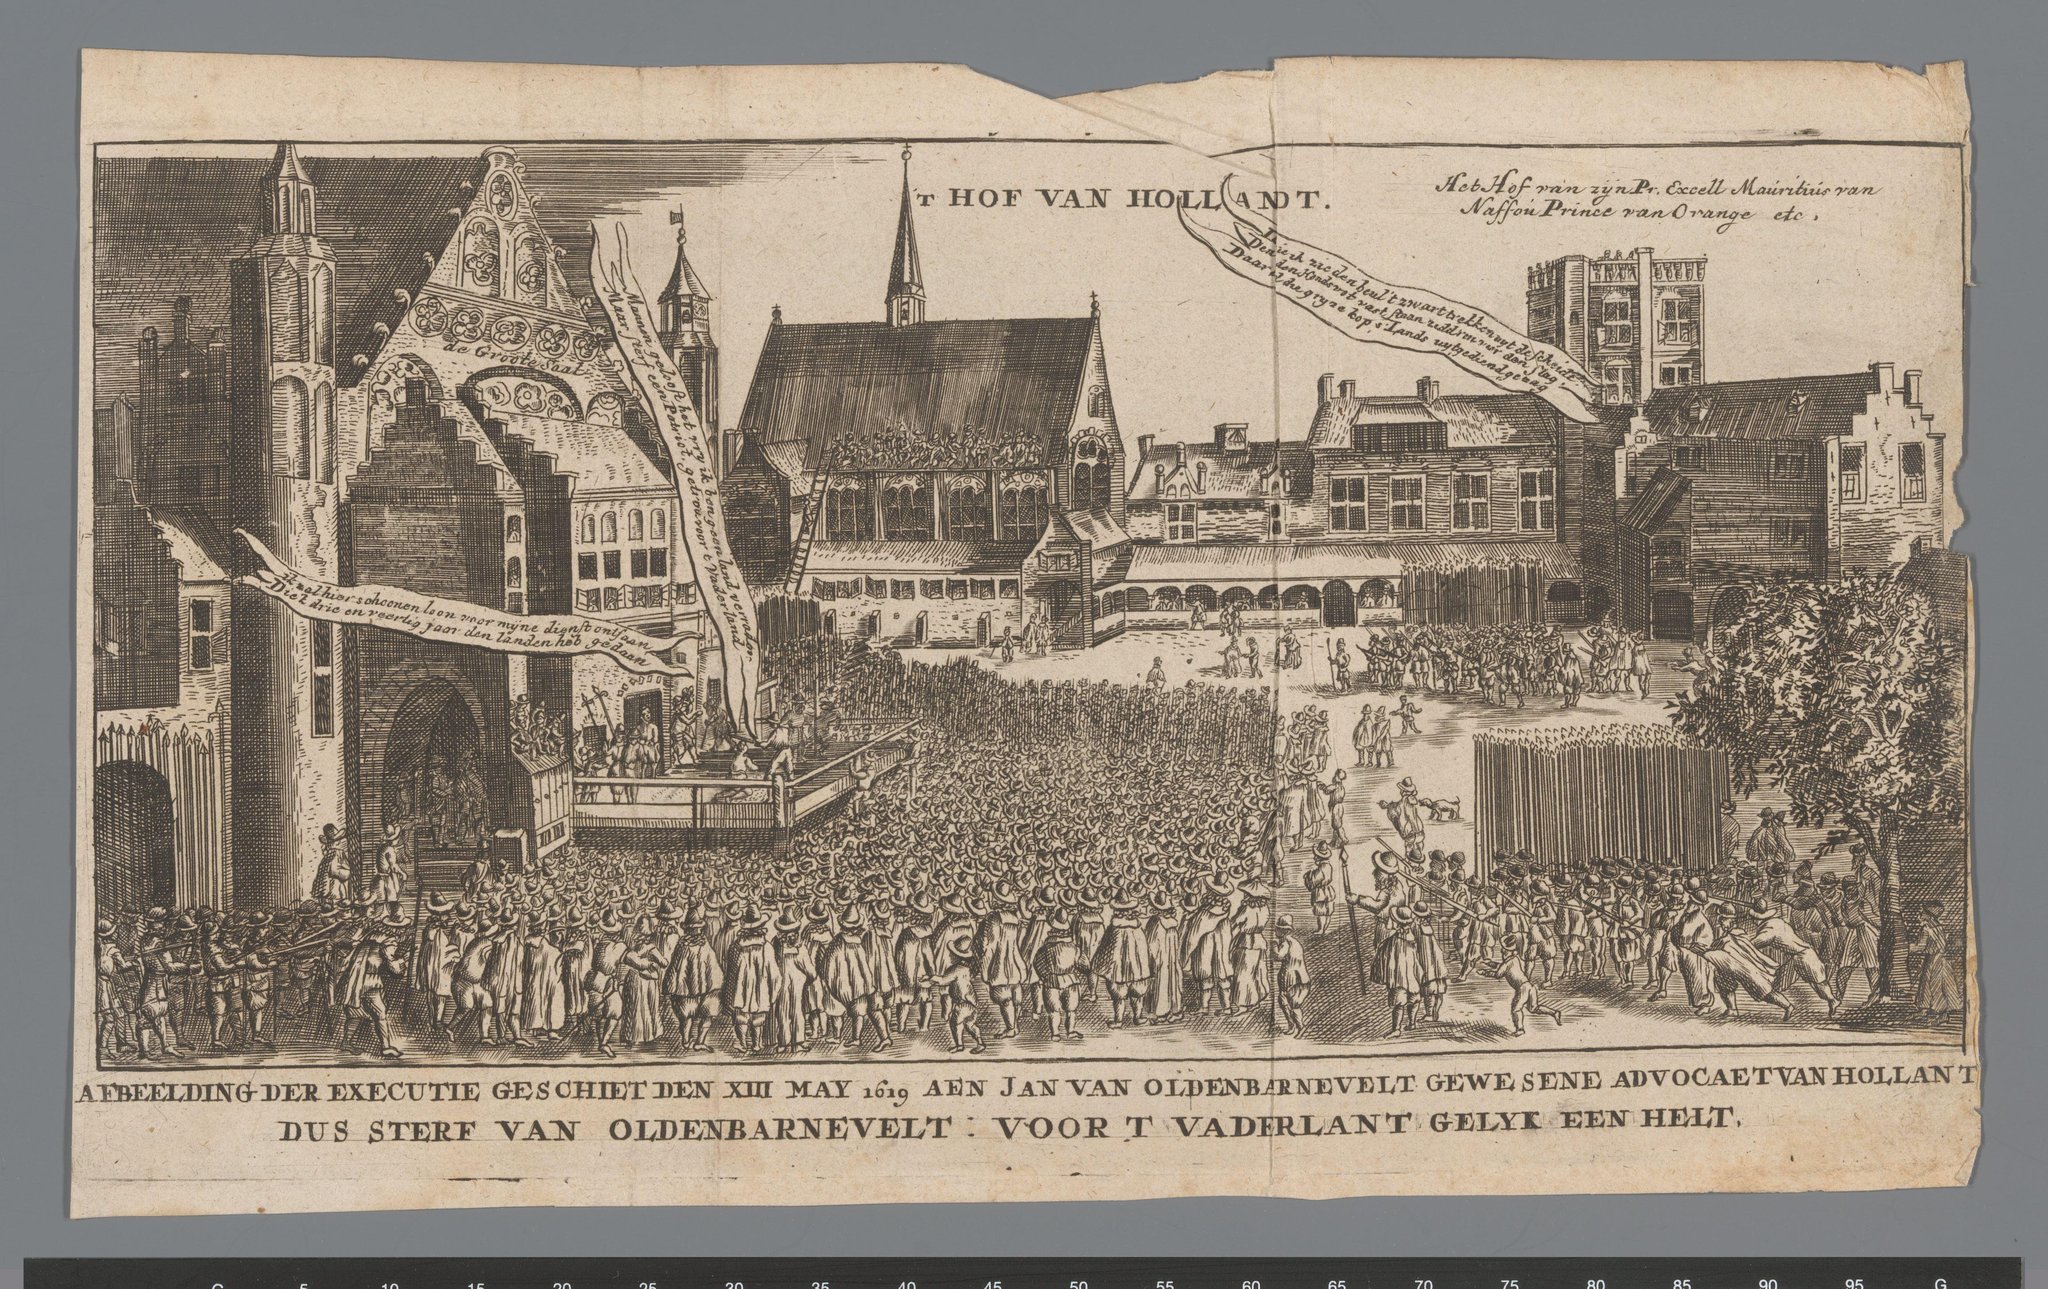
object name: print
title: De onthoofding van Johan van Oldenbarnevelt, 1619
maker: Anonymous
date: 1707-1724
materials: paper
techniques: engraving, etching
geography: northern netherlands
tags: the hague, johan van oldenbarnevelt, maurice (prince of orange), death penalty, execution, violent death by beheading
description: De onthoofding van Johan van Oldenbarnevelt op het Binnenhof te 's-Gravenhage op 13 mei 1619. Gezicht op het plein met alle omringende gebouwen en het verzamelde publiek. In de toren rechtsboven het hof van prins Maurits. In de voorstelling drie banderollen met uitspraken van Van Oldenbarnevelt en prins Maurits.